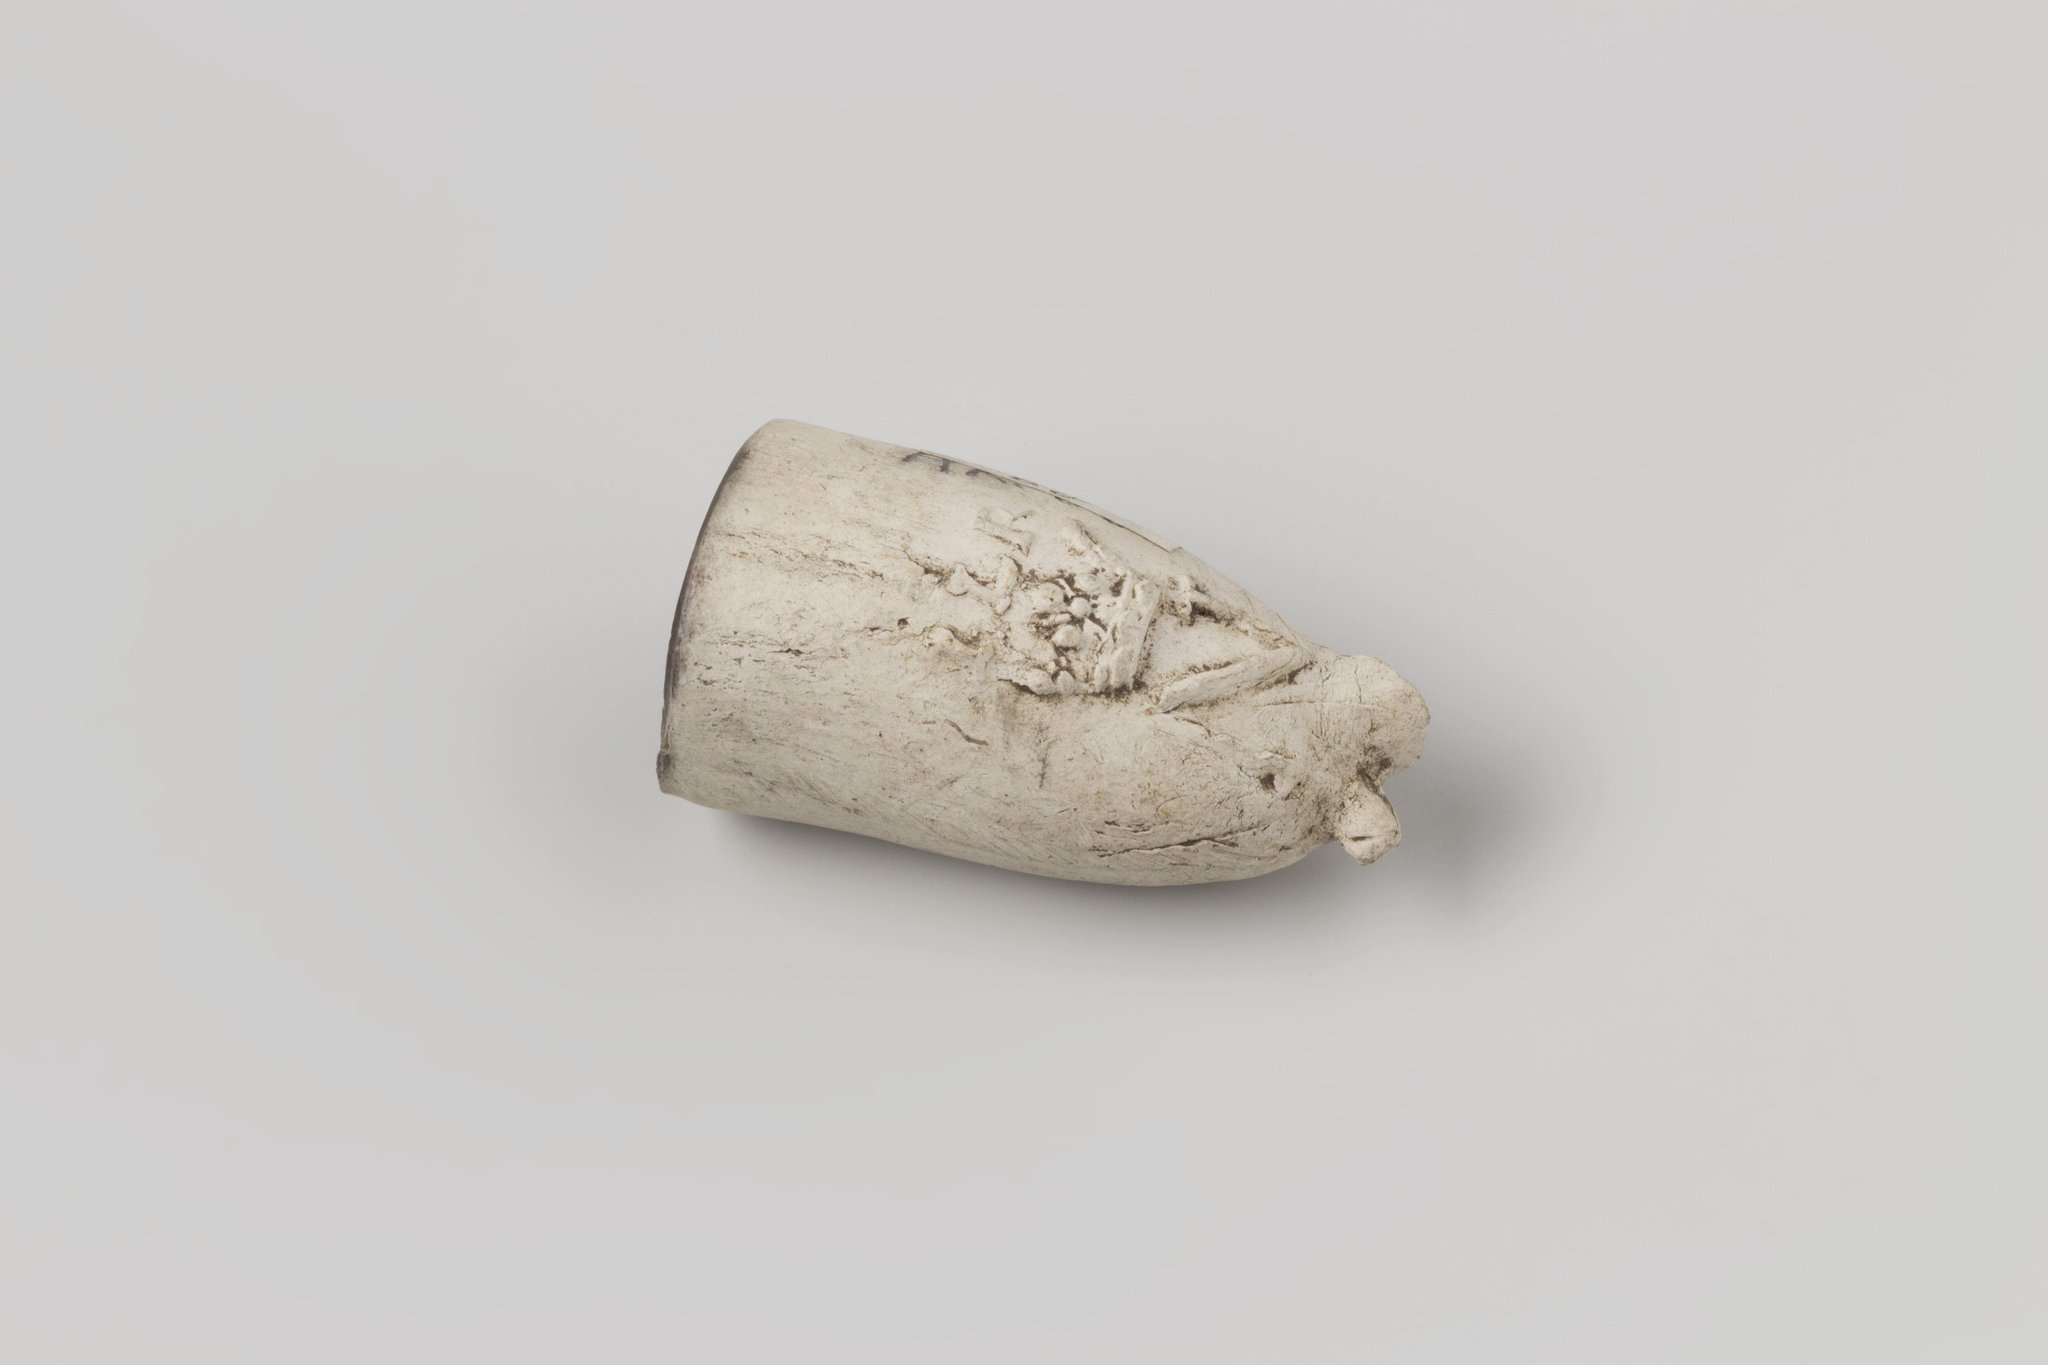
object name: fragment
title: Fragment pijpenkop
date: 1780-1800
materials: clay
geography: schoonhoven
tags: directeur, hoogleraar, caspar jacob christiaan reuvens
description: Fragment pijpenkop met een kroon en de letters I L R en N afgebeeld. Van de opgravingen op de Hofstede Arentsburg 1827-1831 onder toezicht van Professor Reuvens.